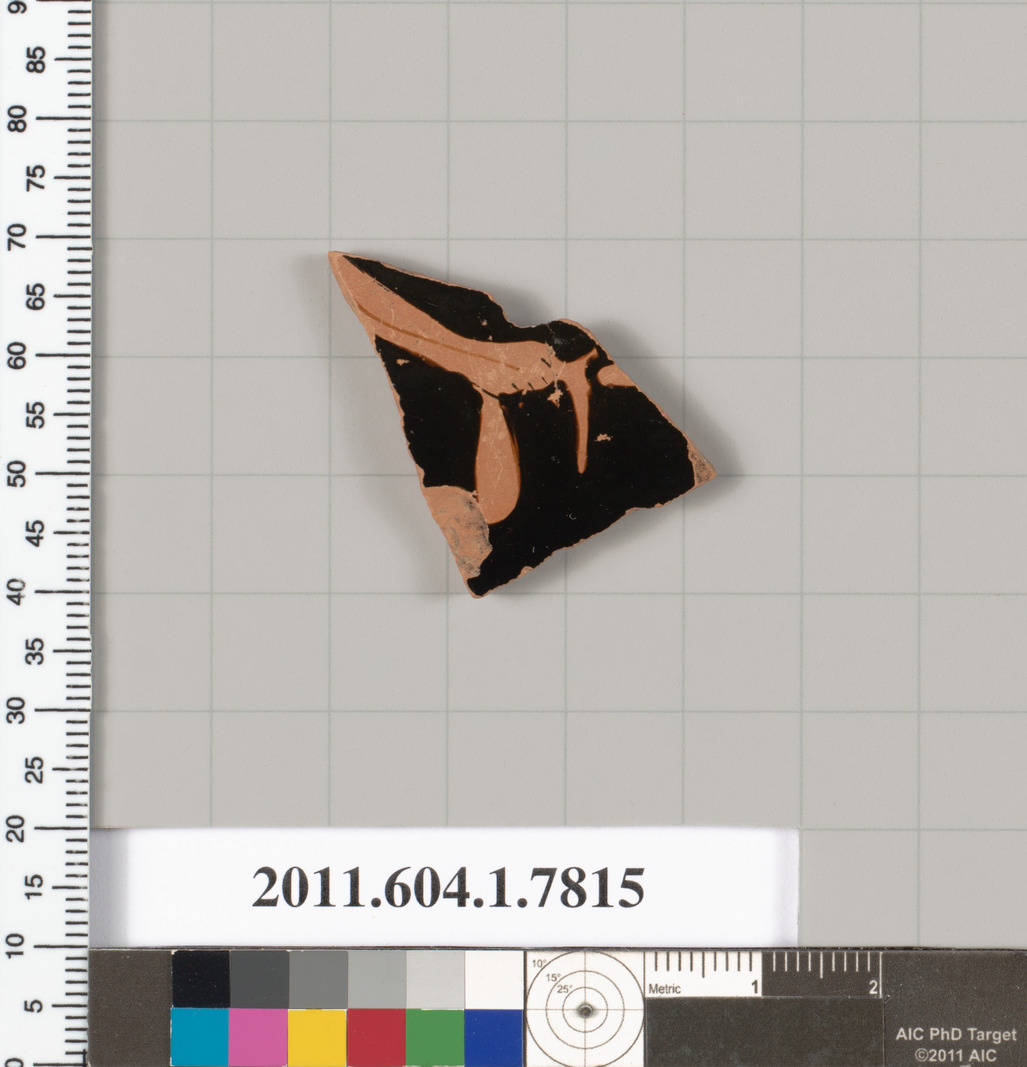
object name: kylix fragment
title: Terracotta fragment of a kylix (drinking cup)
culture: greek, attic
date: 460-450 BCE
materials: terracotta